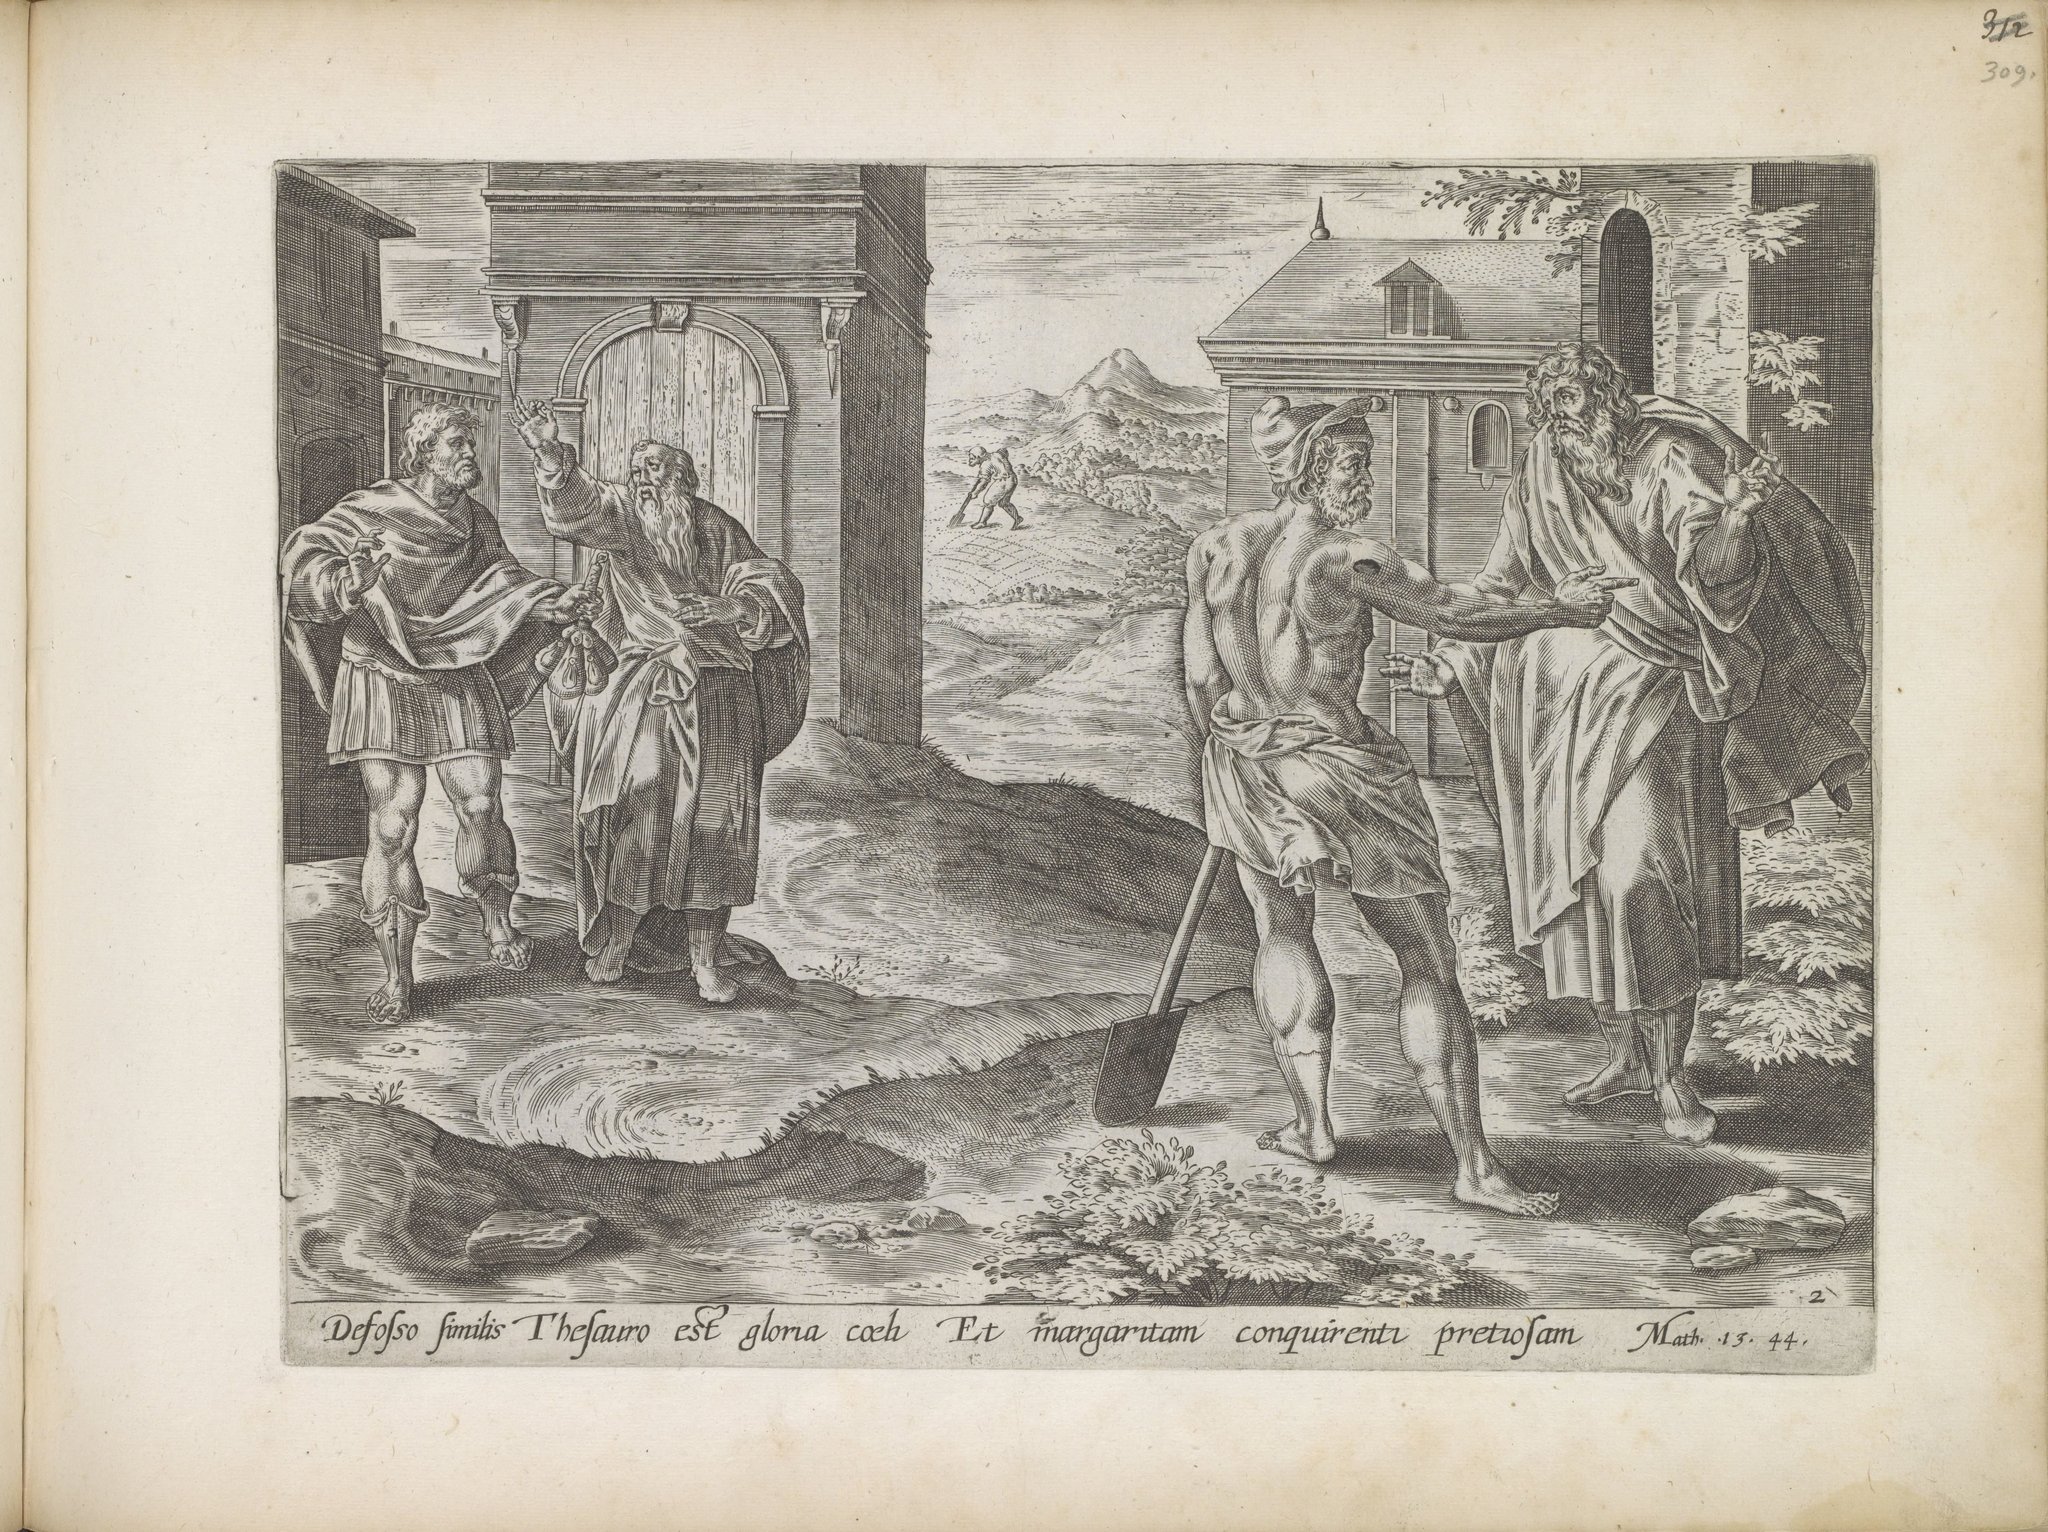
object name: album leaf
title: Gelijkenis van de schat in de akker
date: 1585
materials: paper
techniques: engraving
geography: amsterdam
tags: 'the kingdom of heaven is like treasure hidden in a field' ~ proverbial saying of christ (matthew 13:44)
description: Een man koopt nadat hij in een akker een schat heeft gevonden de akker van de eigenaar. Op de achtergrond is te zien hoe de man de schat vindt en weer begraaft. Op de voorgrond staat de man met een stokkenbeurs in de hand om te onderhandelen en de akker te kopen. Onder de voorstelling een verwijzing in het Latijn naar de Bijbeltekst in Mat. 13:44. Deze prent maakt deel uit van een album.